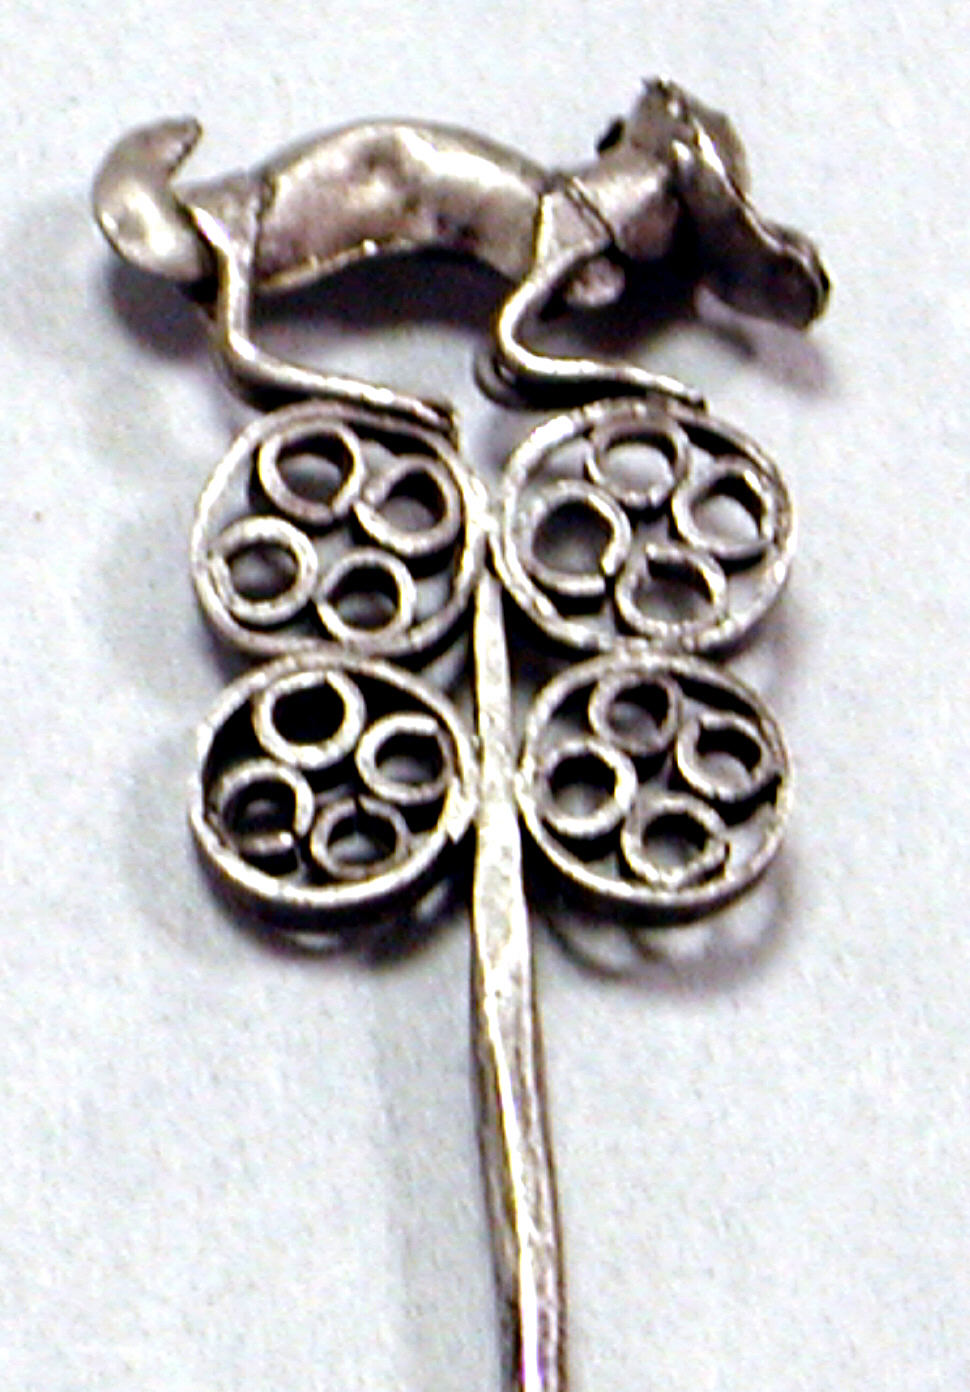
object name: pin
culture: chimú or inca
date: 1301-1500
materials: silver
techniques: hammering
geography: peru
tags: animals